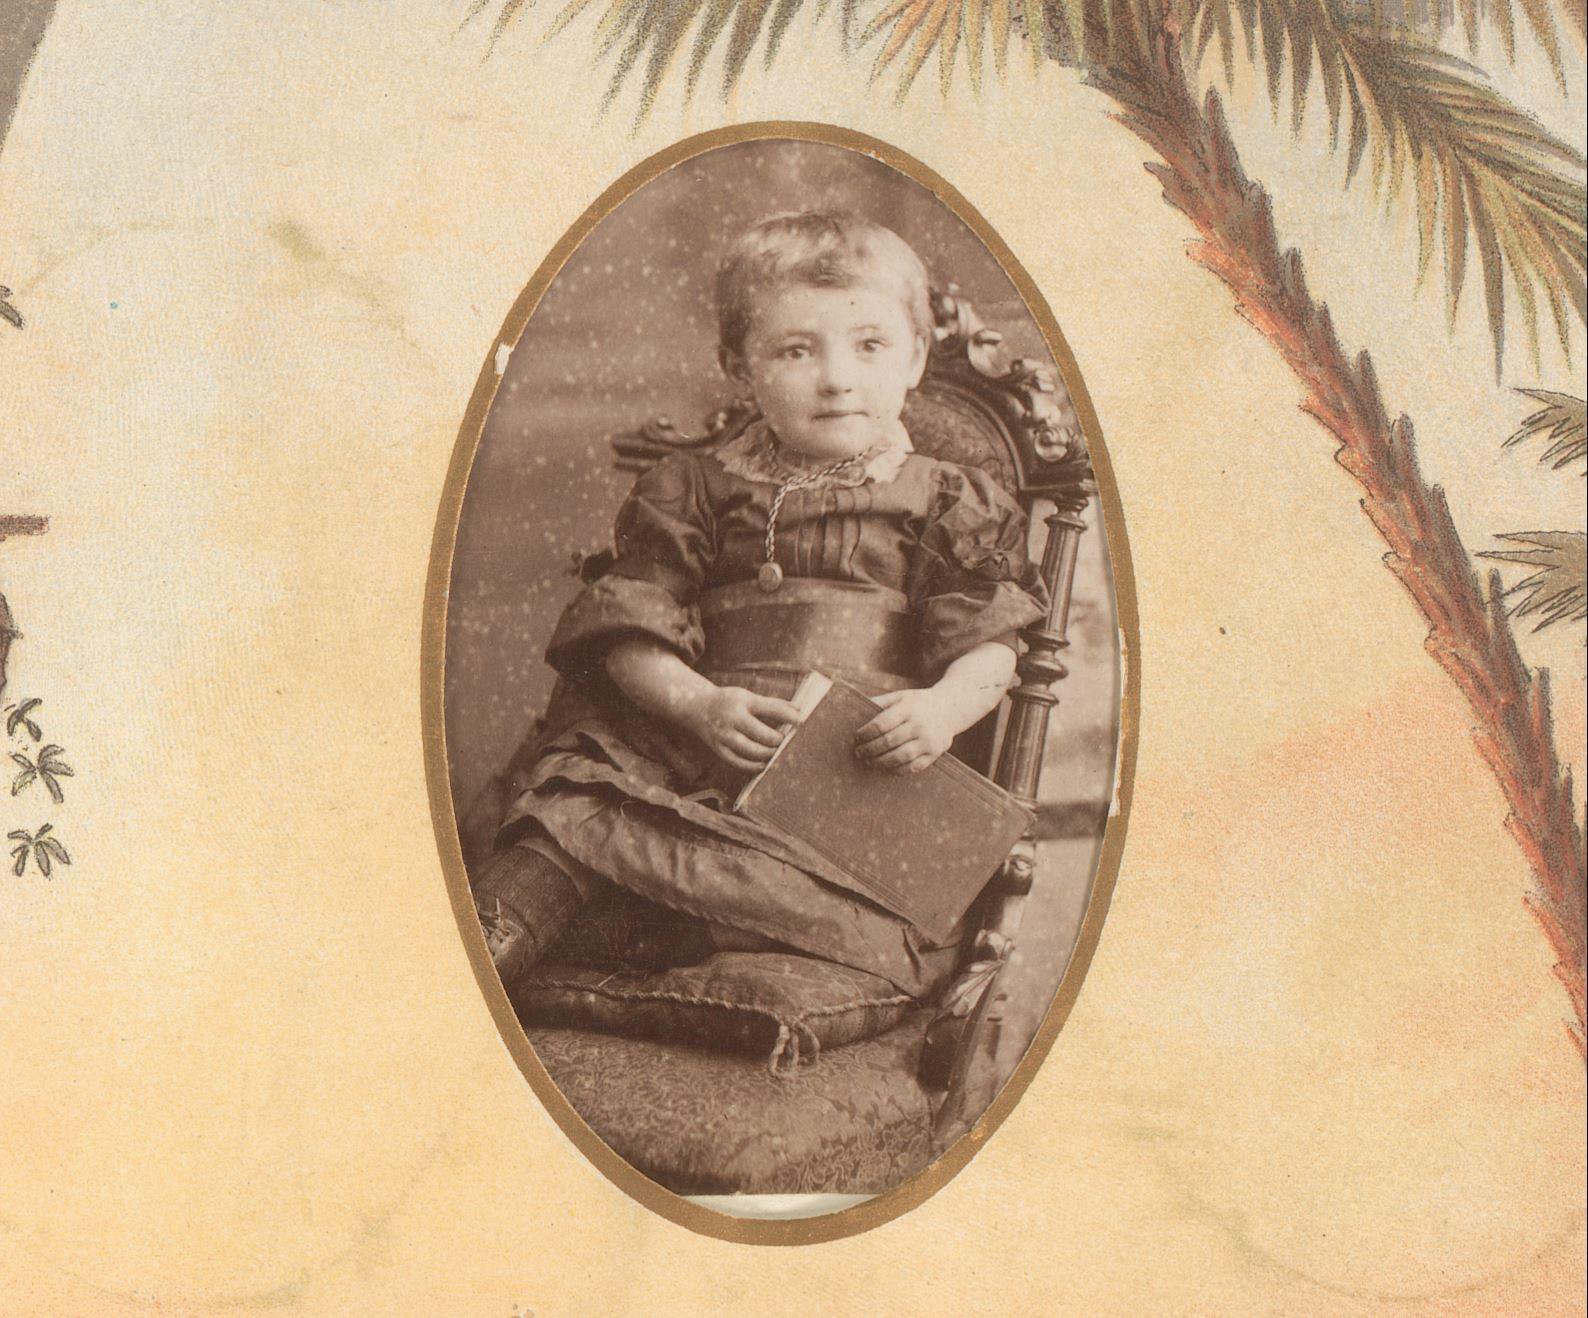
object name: photograph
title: Portret van een zittend kind met boek in de hand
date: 1887-1900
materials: cardboard, photographic support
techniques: albumen print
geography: newcastle upon tyne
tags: sitting figure, child, historical persons, book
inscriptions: inscription: ‘AWARDED 1883, 1885 & 1887./ (...)/ P. M. LAWS & SON/ Gallery of Photography./ 38, Blackett St./ Opposite Grey's Monument./ Newcastle on Tyne’